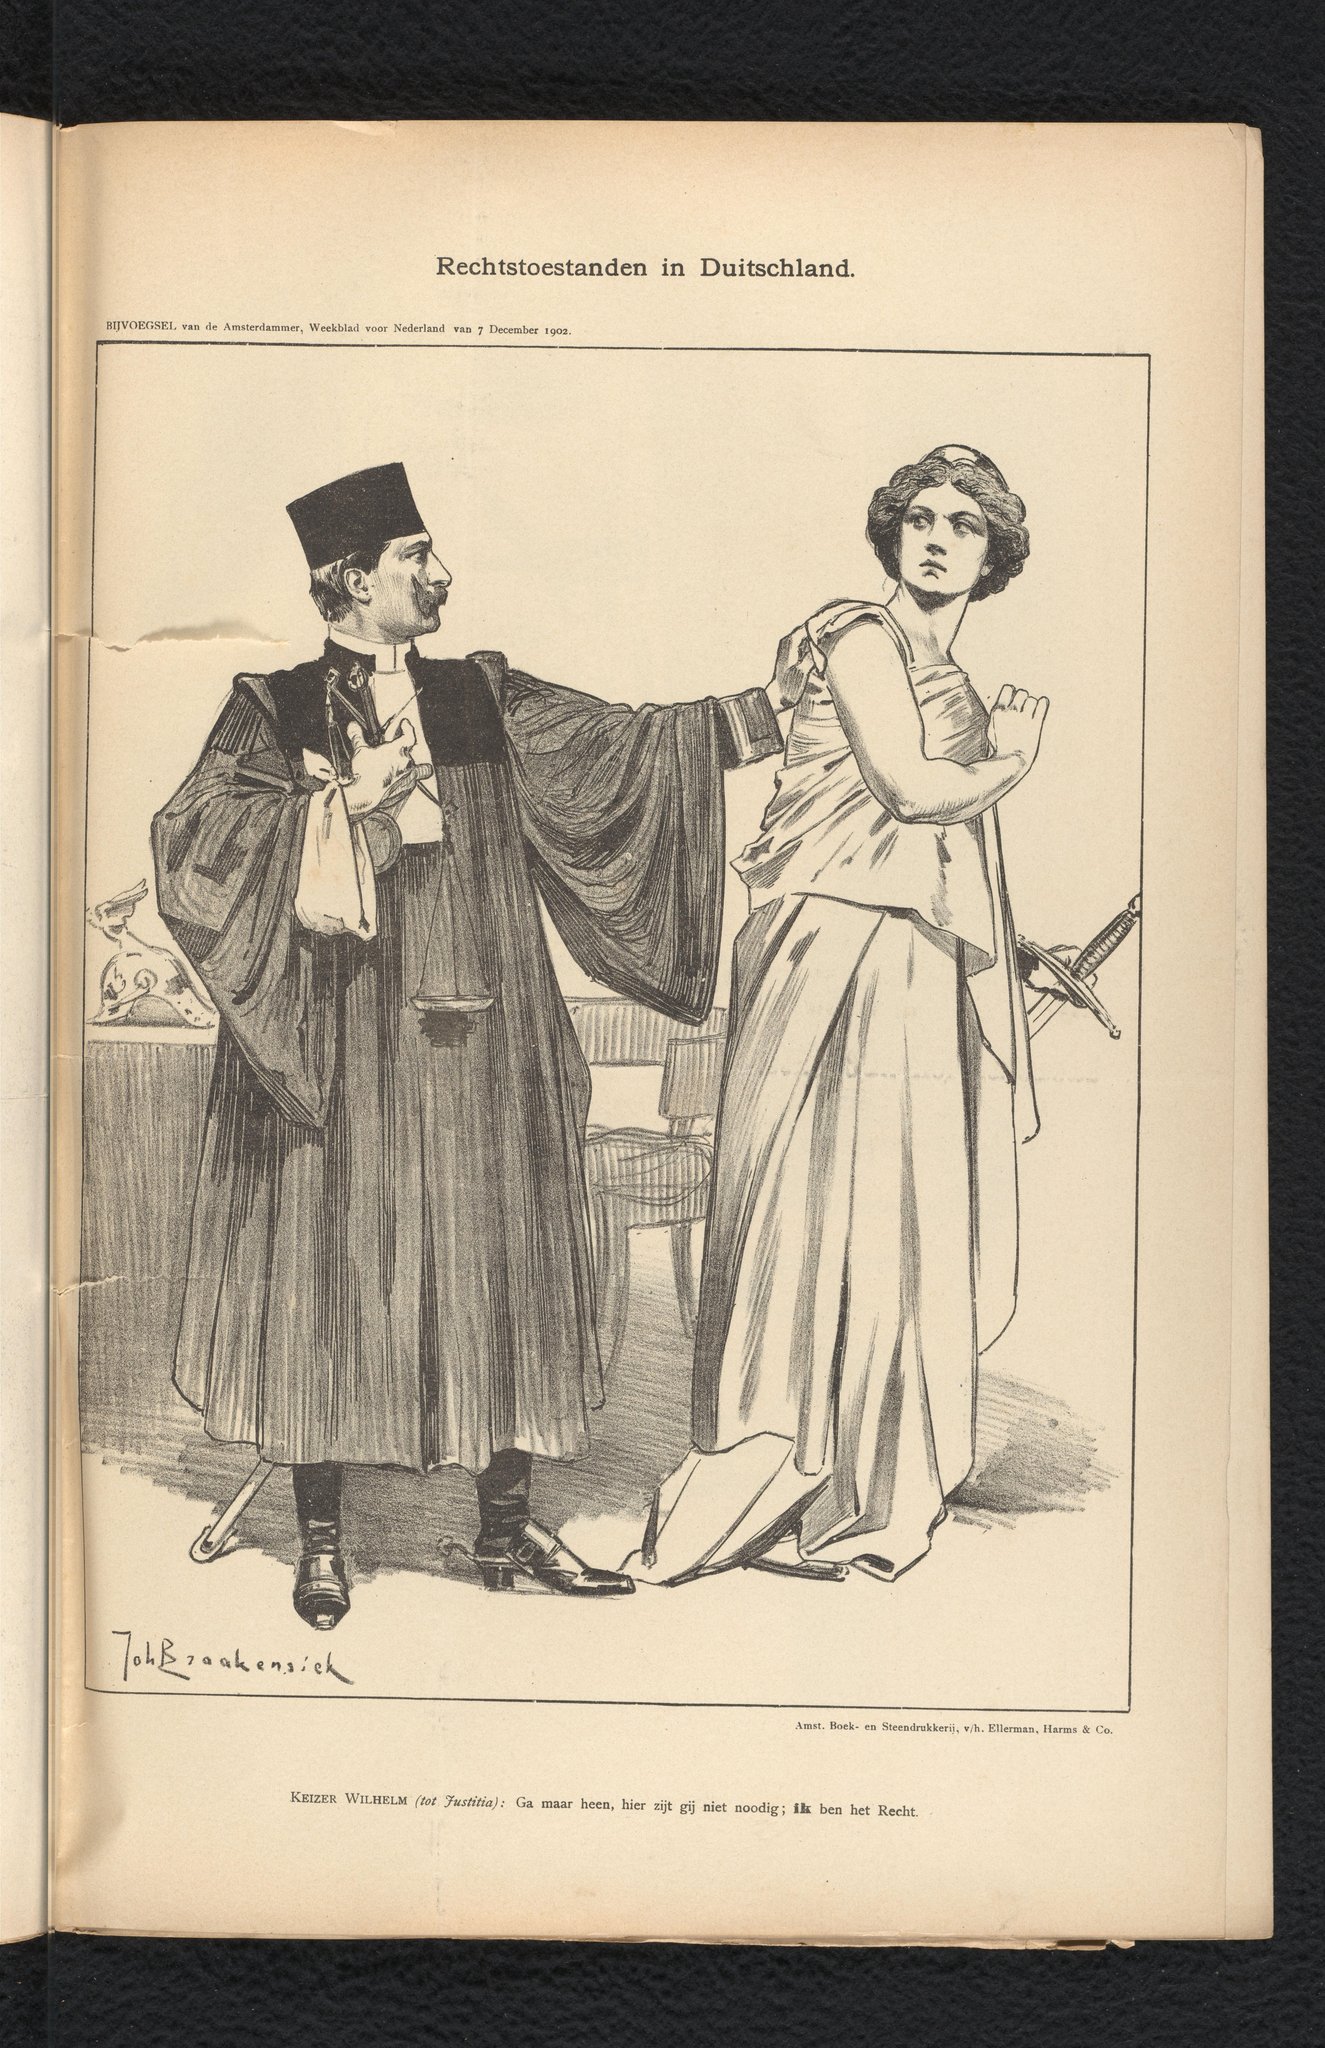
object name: cartoon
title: Rechtstoestanden in Duitschland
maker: johan braakensiek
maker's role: draughtsman, print maker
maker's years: 1858-1940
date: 1902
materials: paper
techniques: lithograph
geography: amsterdam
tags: wilhelm ii (keizer van duitsland), justice, 'justitia'; 'giustitia divina' (ripa) ~ one of the four cardinal virtues, political caricatures and satires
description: Gepubliceerd als bijvoegsel bij 'De Amsterdammer' van 7 december 1902.